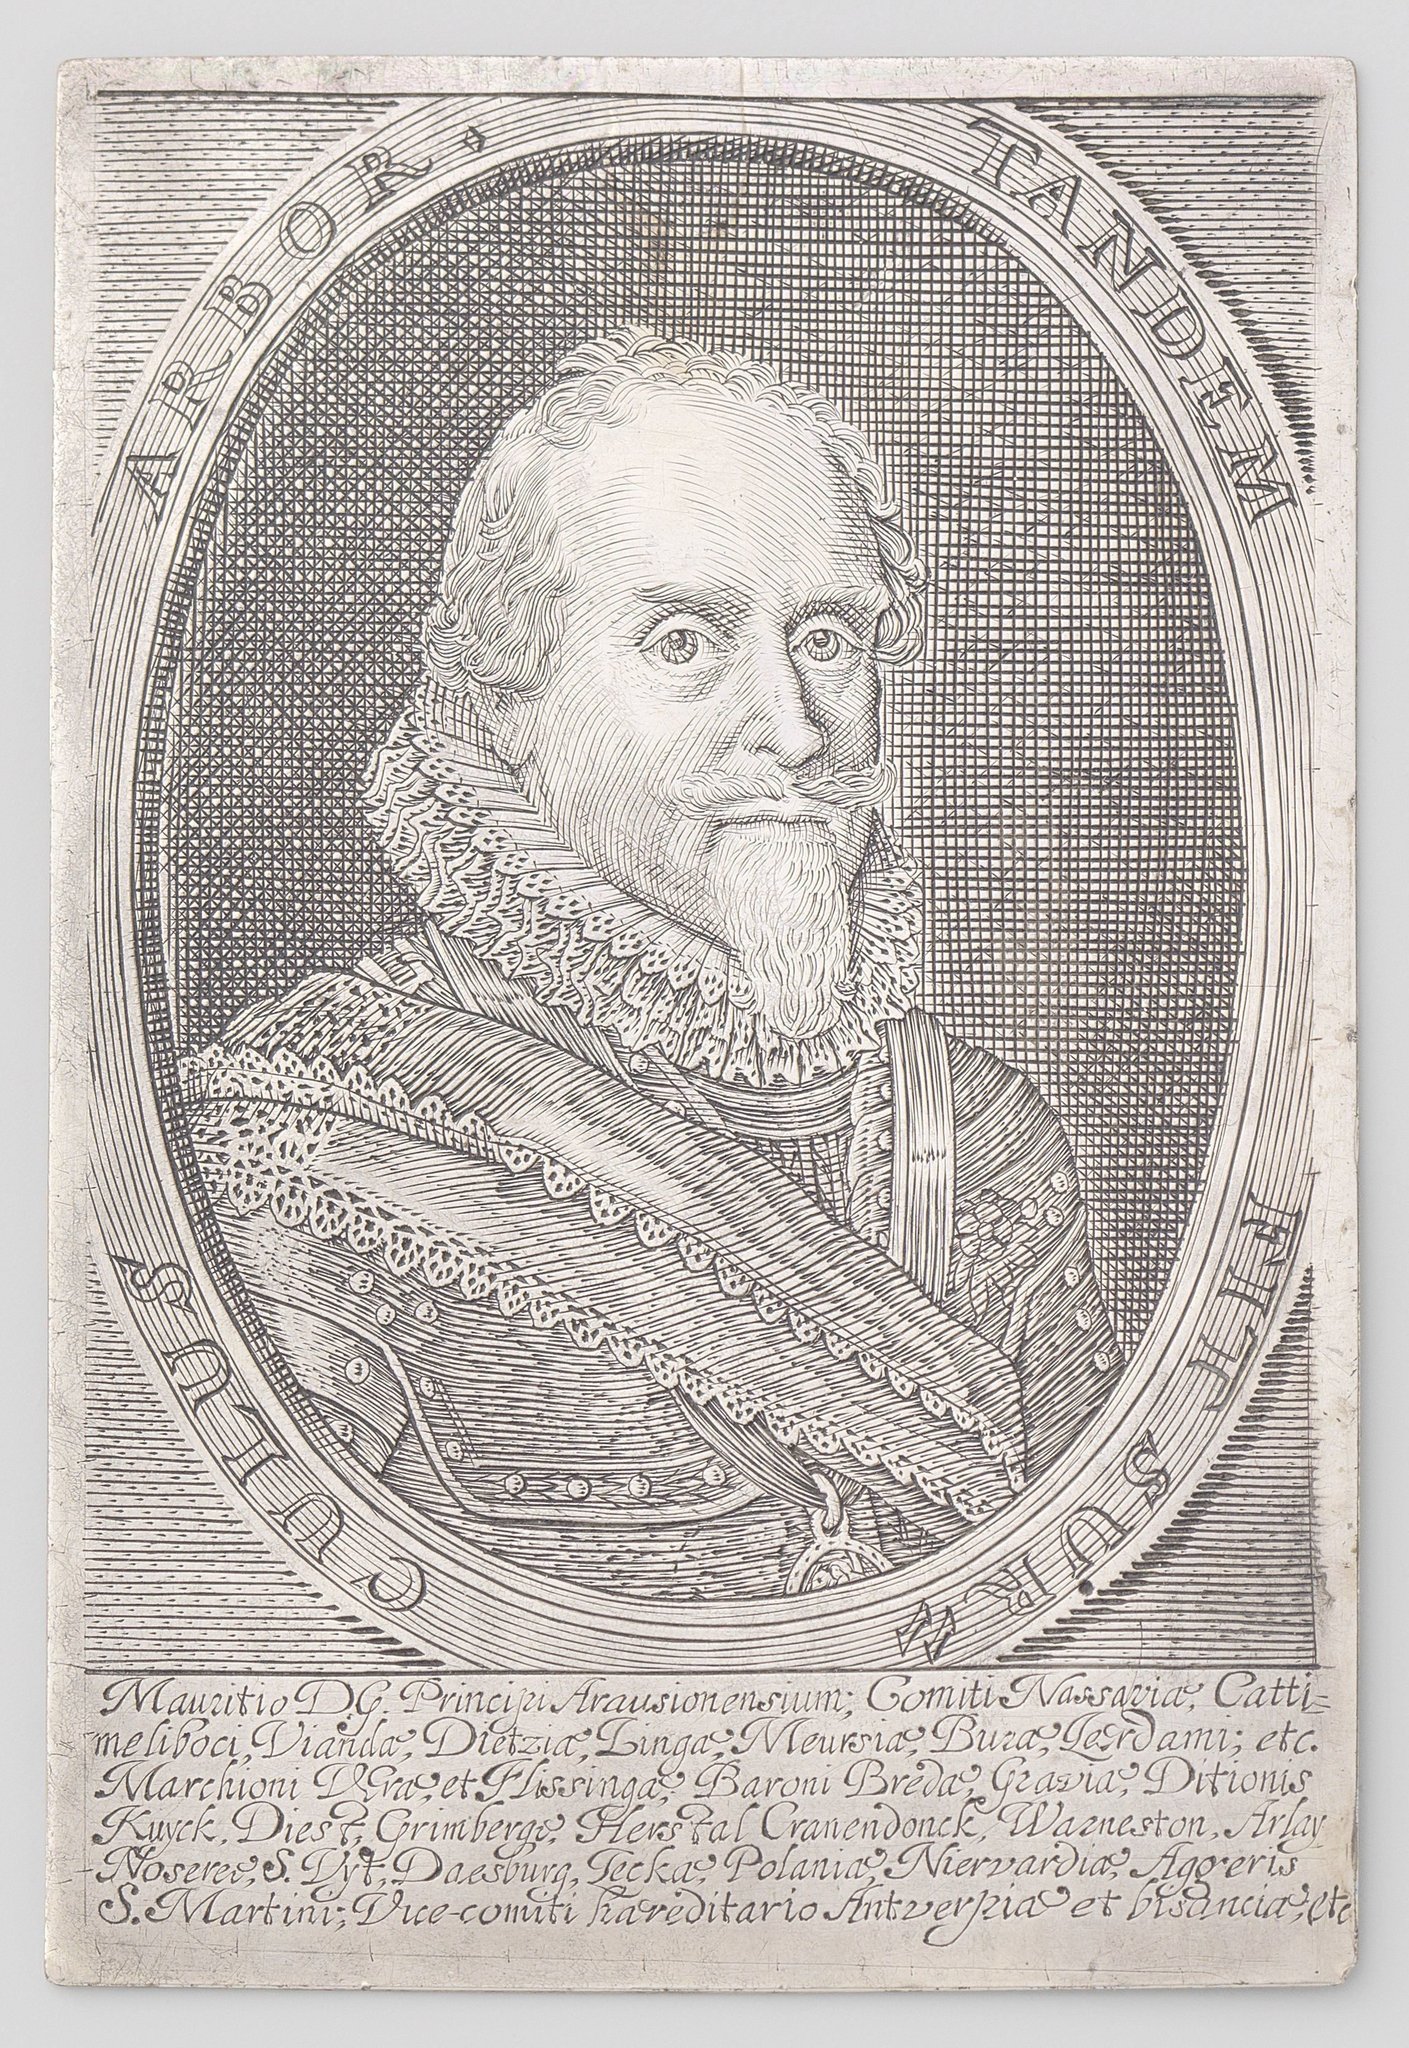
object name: plate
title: Portret van prins Maurits van Nassau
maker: Anonymous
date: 1625-1675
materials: silver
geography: netherlands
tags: the hague, maurice (prince of orange), historical persons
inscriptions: : ‘TANDEM FIT SURCULUS ARBOR’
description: Portret gegraveerd op zilver van prins Maurits van Nassau, prins van Oranje, Stadhouder. Met rondom een opschrift: TANDEM FIT SURCULUS ARBOR. Waaronder in het Latijn zijn titels. Pendant van BK-NM-197.